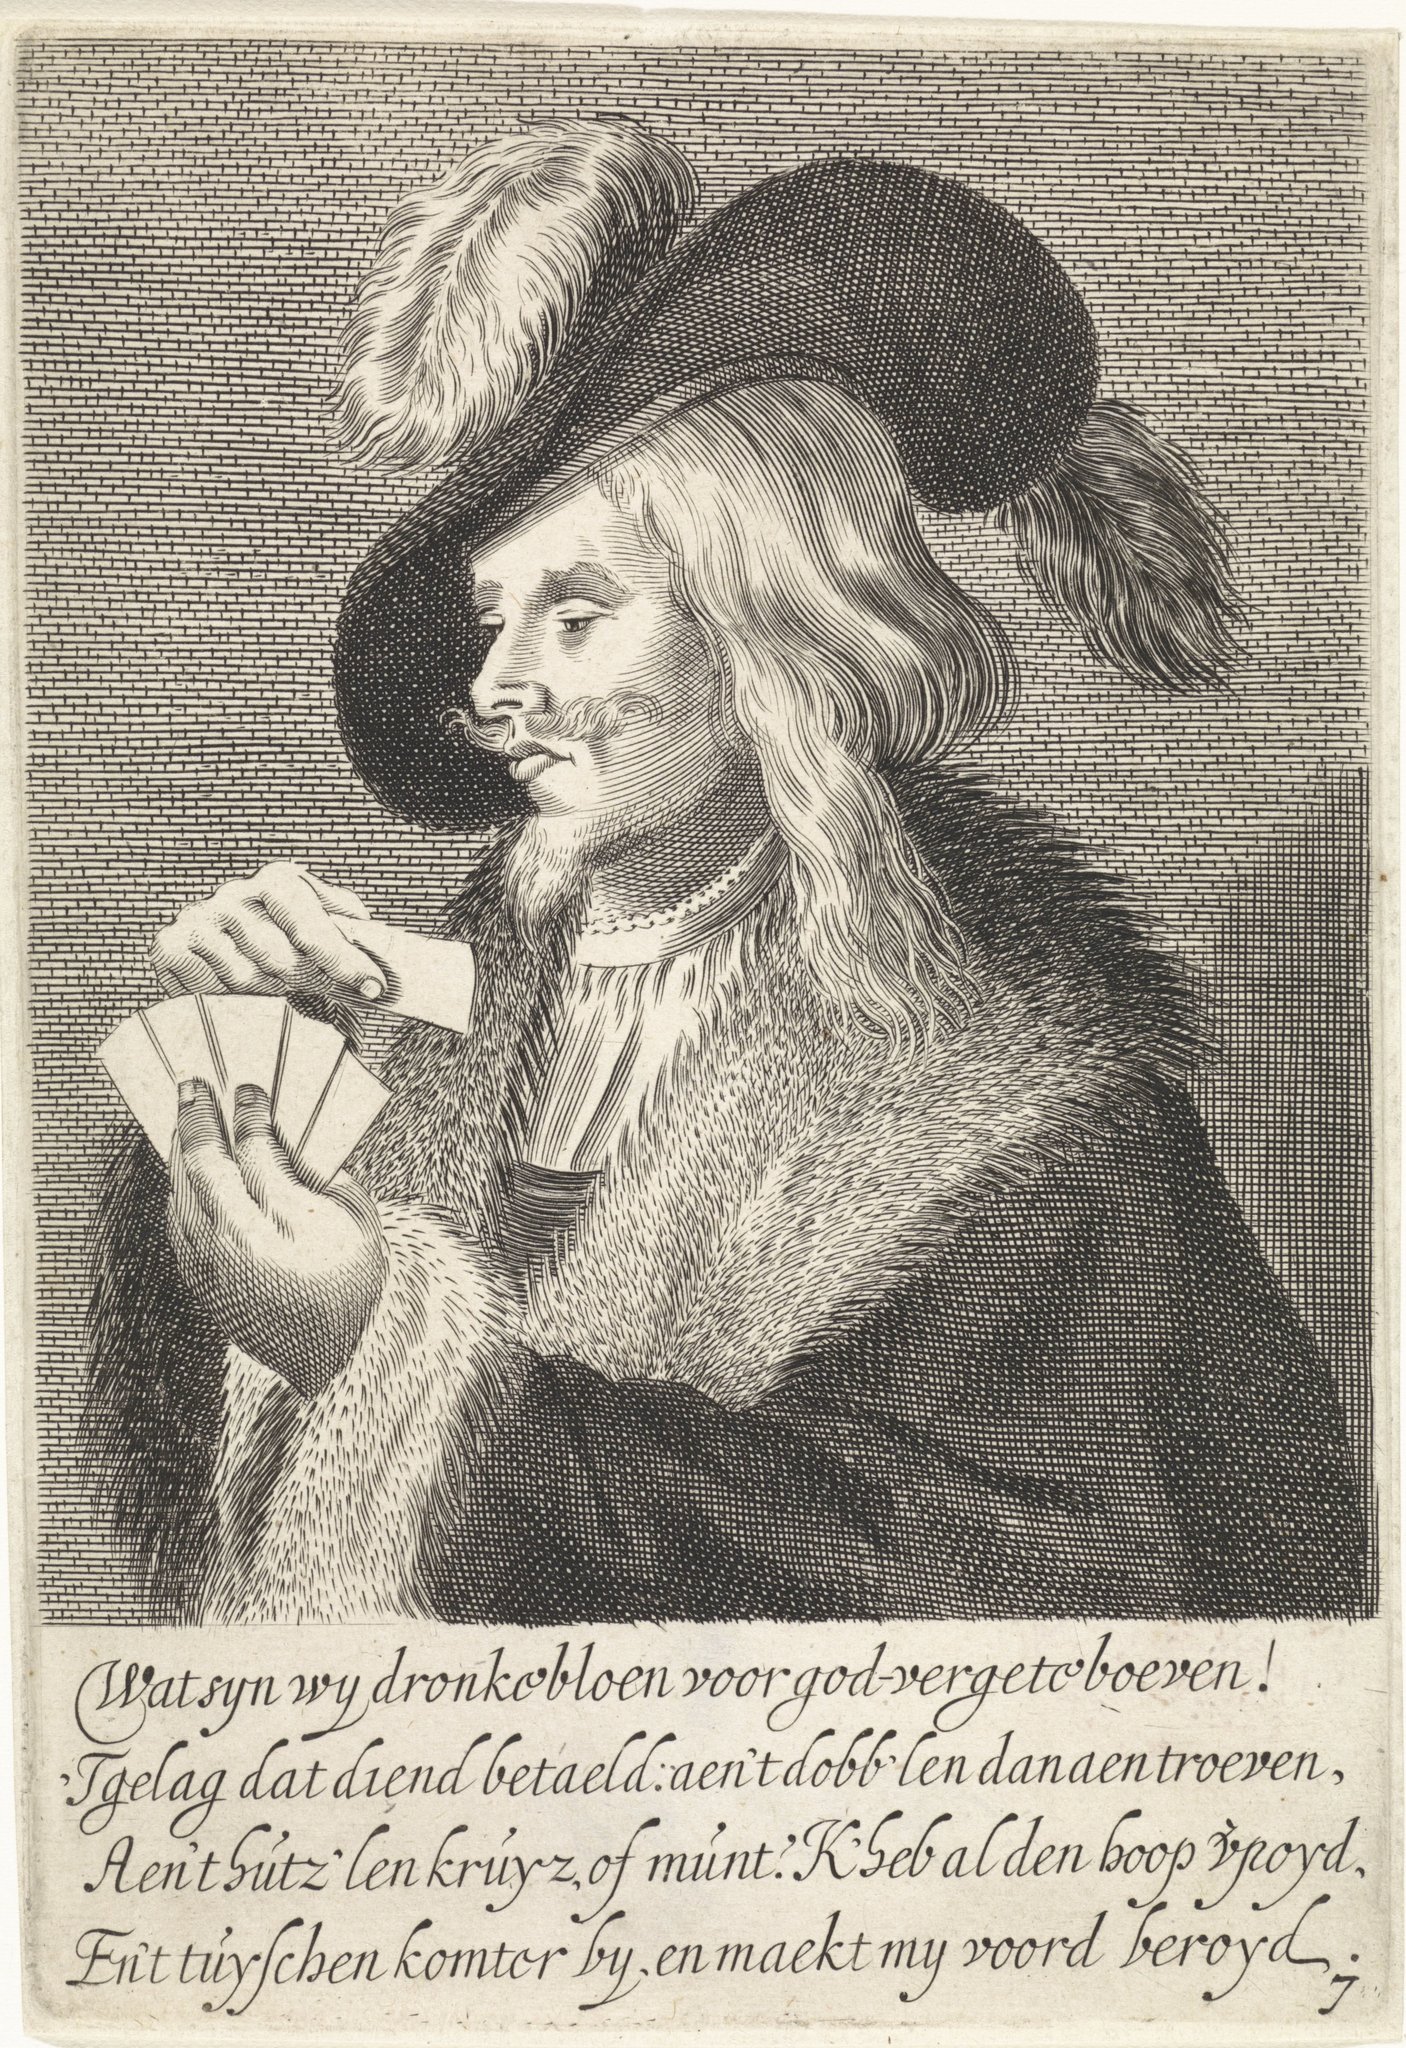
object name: print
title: Losing Card Player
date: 1633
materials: paper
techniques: engraving, etching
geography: amsterdam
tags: youth, adolescent, card games, playing-cards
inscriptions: collector's mark: Lugt 240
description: In 1633, a year after the death of the Haarlem minister and writer Samuel Ampzing, the Spigel, a series of 17 prints with his didactic verses, was published. Pendants like this tric-trac player and card-player and trios of half-figures brought attention to the popular moralizing message of the consequences of vanity and drinking in an unconventional way.